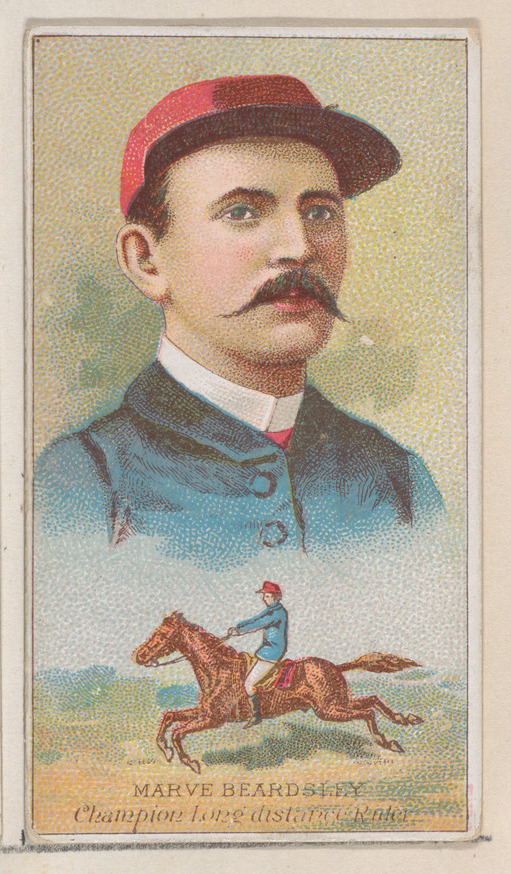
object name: print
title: Marv Beardsley, Champion Long Distance Rider, from the Champions of Games and Sports series (N184, Type 2) issued by W.S. Kimball & Co.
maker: w.s. kimball & co.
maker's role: publisher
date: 1887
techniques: color lithograph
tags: men,horses,athletes